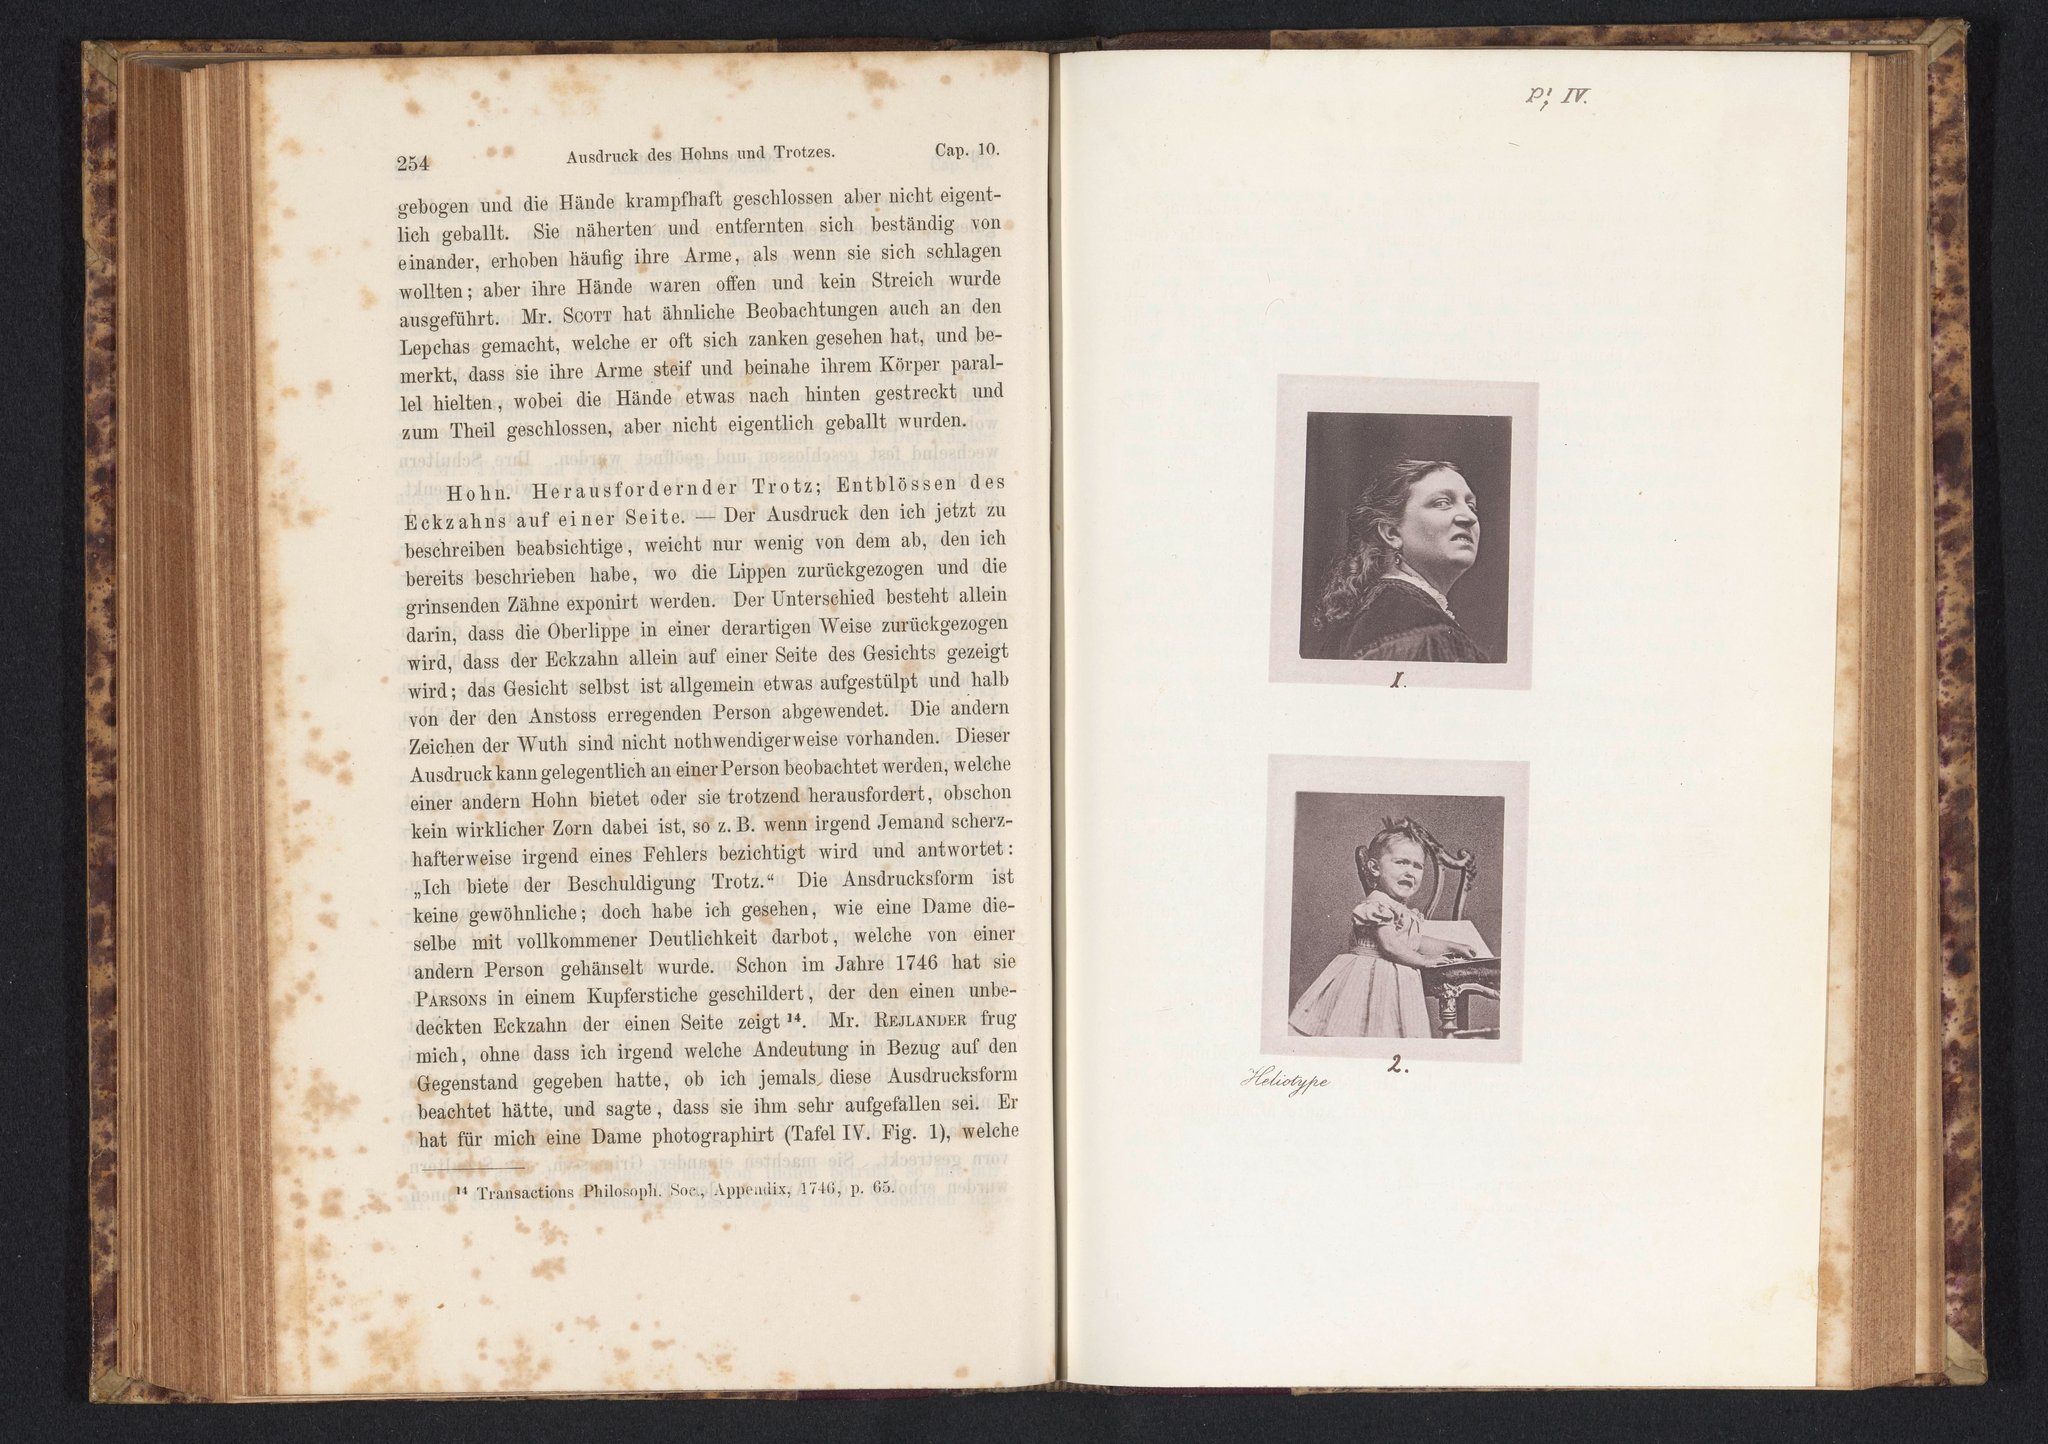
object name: photomechanical print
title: Twee portretten van een onbekende vrouw en een kind die woede en spot tonen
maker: Anonymous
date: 1862-1872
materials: paper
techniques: photoaquatint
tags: passions, emotions, affections, rage, anger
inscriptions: number: ‘Pl. IV. 1. 2.’